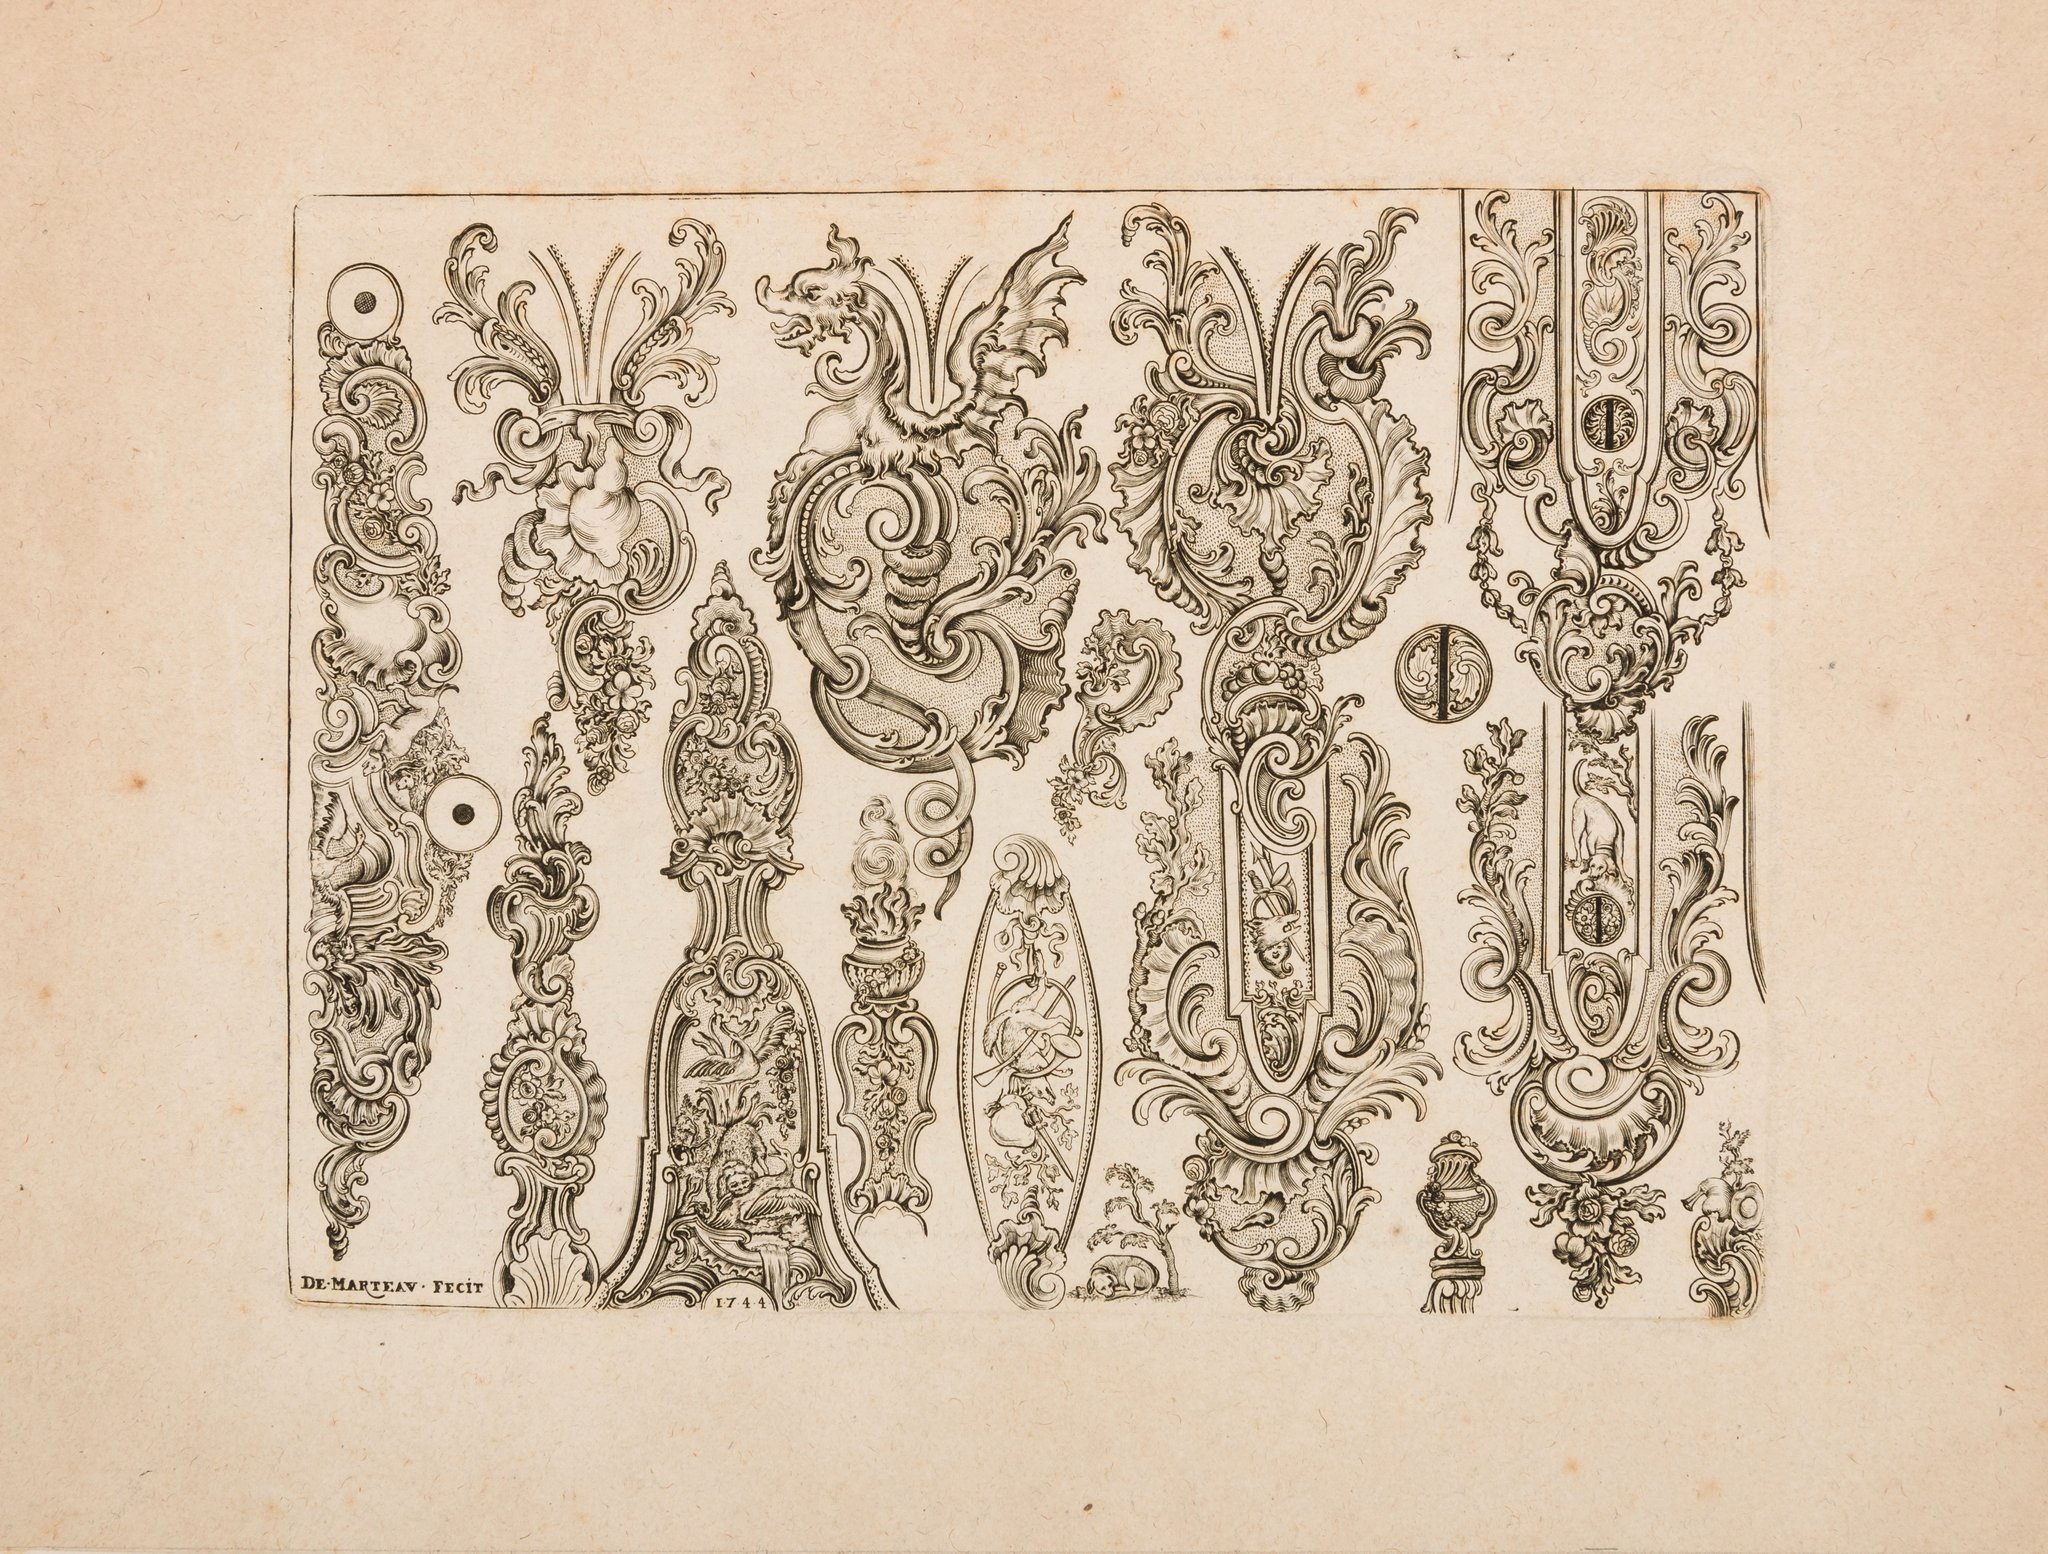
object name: engraving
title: Plate Ten from Nouveavx Desseins D’Arquebvseries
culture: french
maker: gilles demarteau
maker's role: engraver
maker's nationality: french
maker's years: 1722-1776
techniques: engraving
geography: france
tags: ornament